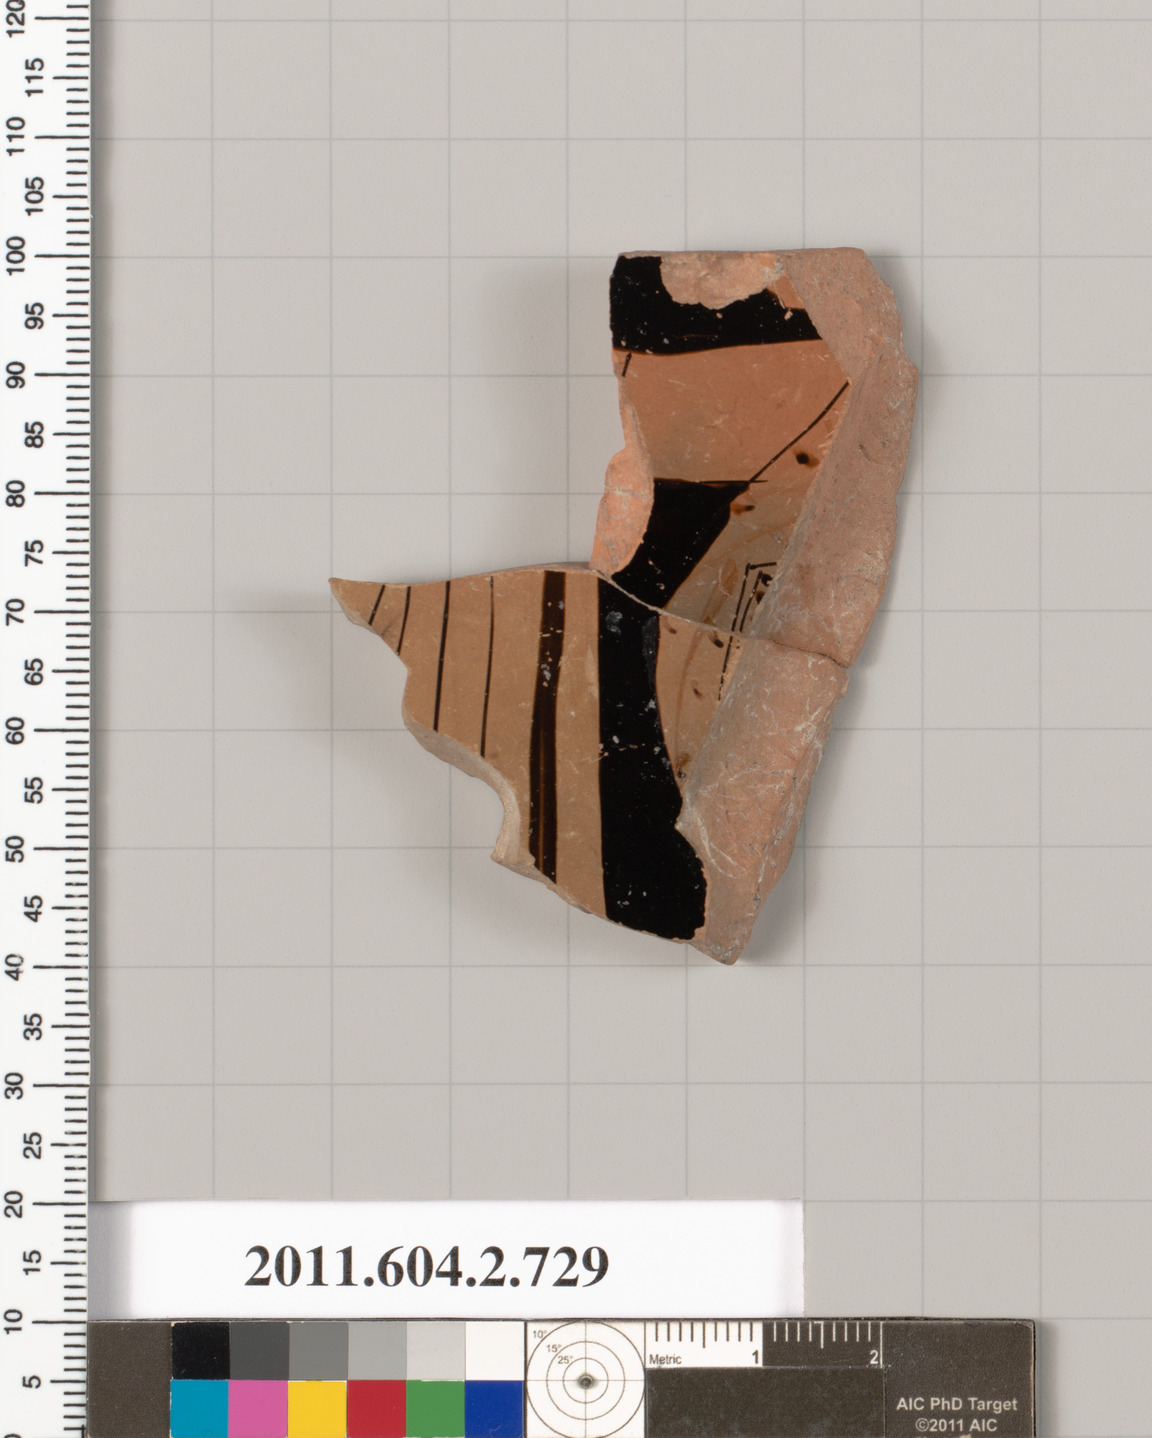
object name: calyx krater fragment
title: Terracotta fragment of a calyx-krater (bowl for mixing wine and water)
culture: greek, attic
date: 440-430 BCE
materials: terracotta